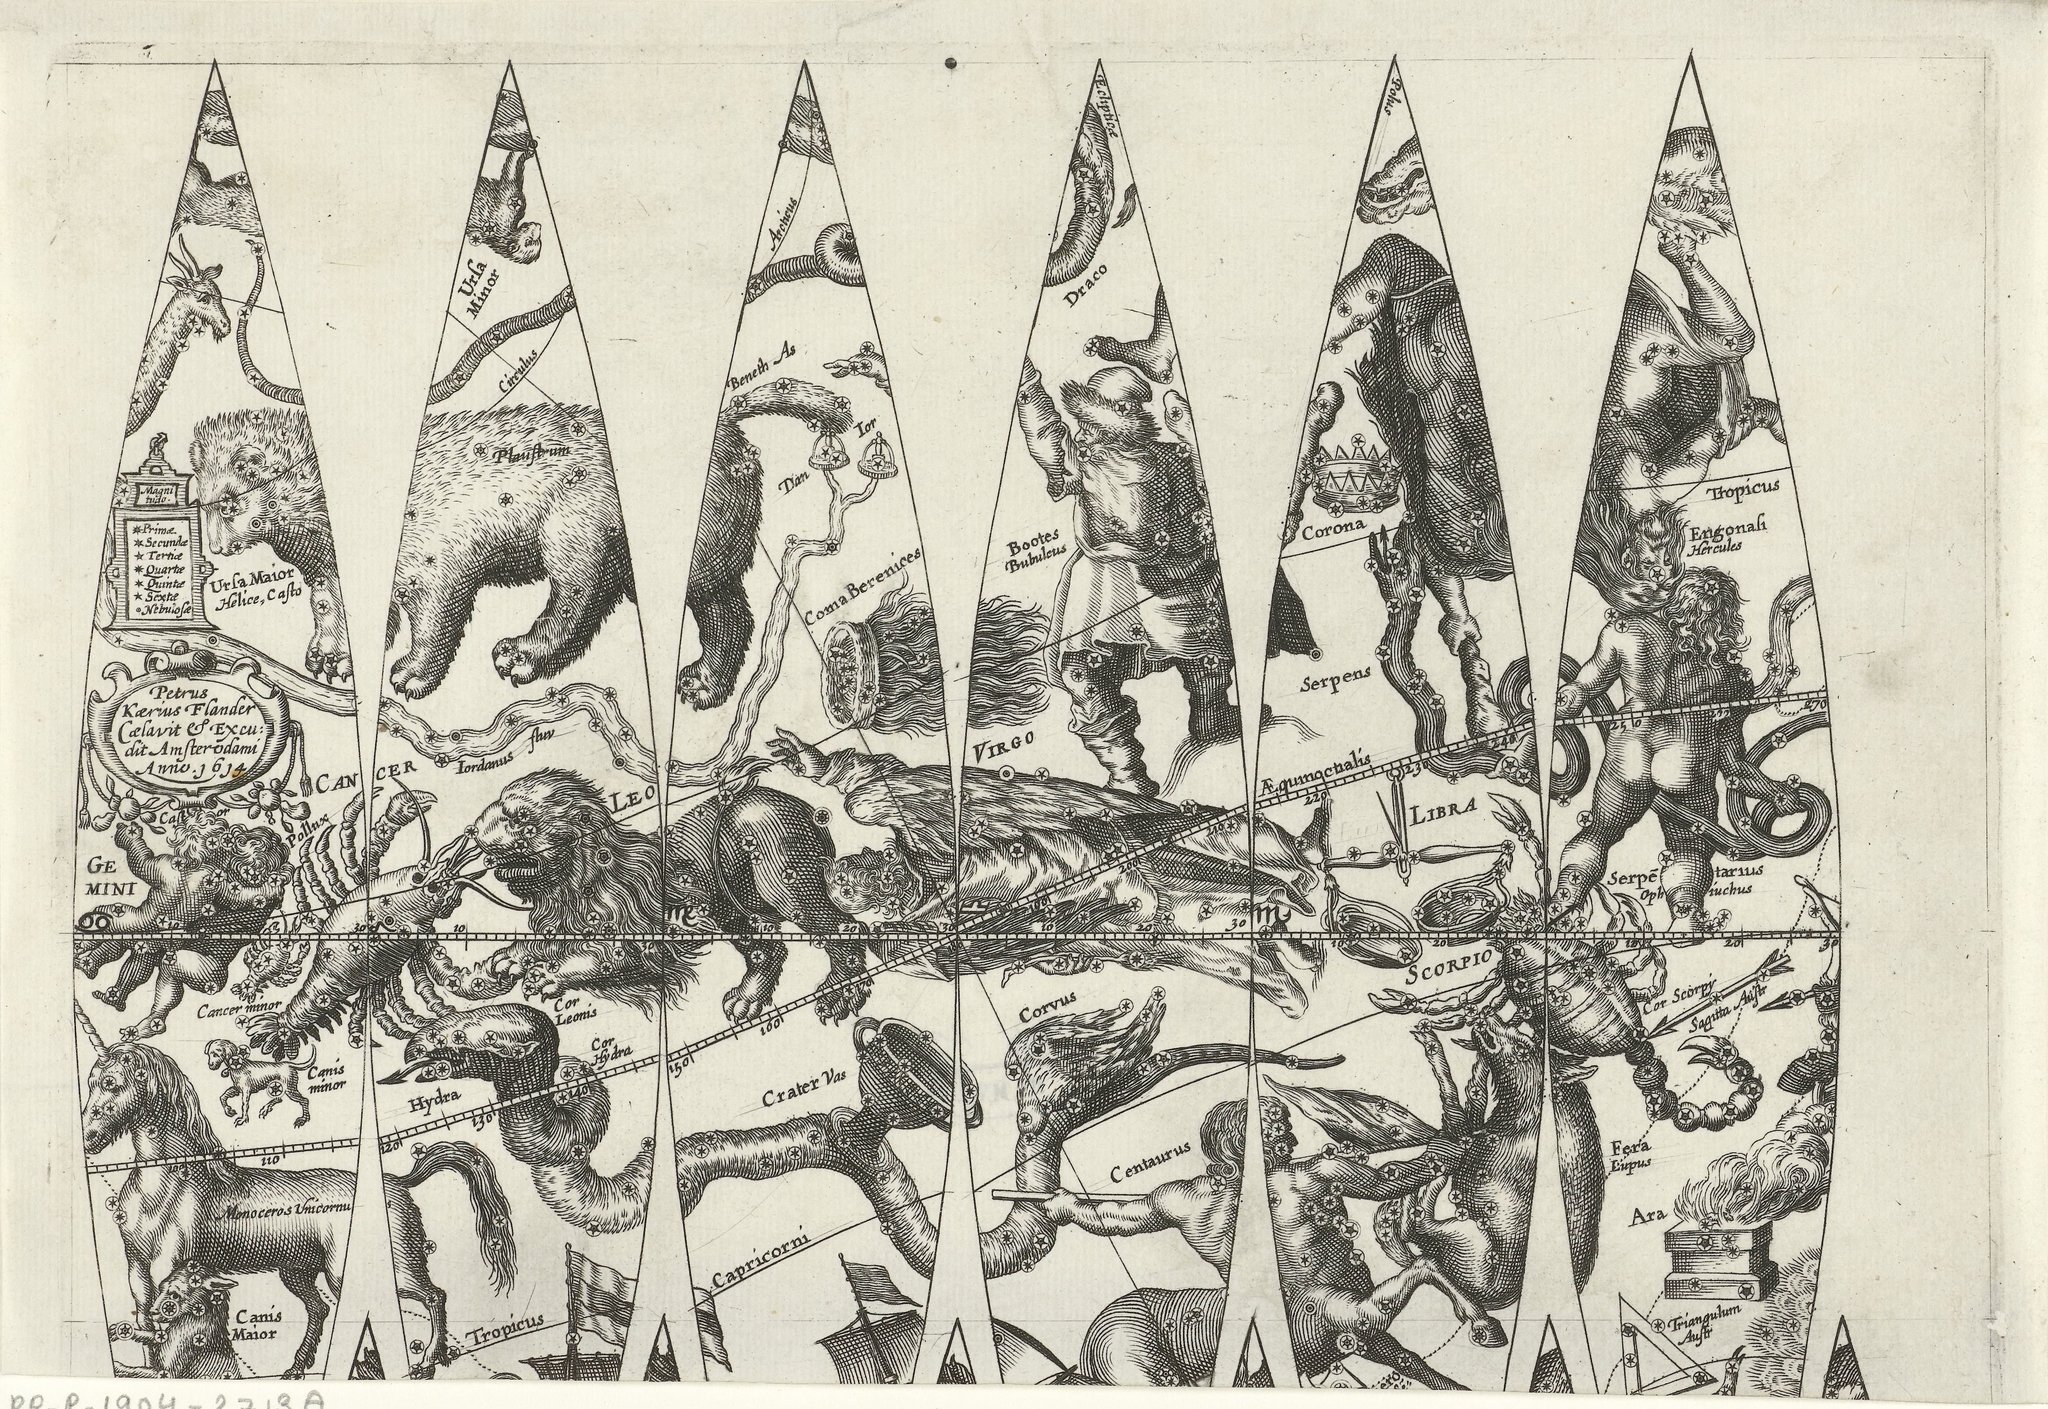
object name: print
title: Kaart van een gedeelte van de dierenriem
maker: pieter van der keere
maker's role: print maker, publisher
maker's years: 1571-1646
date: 1614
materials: paper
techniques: engraving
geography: amsterdam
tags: virgo (zodiacal sign of august), cancer (zodiacal sign of june), scorpio (zodiacal sign of october), gemini (zodiacal sign of may), leo (zodiacal sign of july), star-globe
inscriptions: collector's mark: Lugt 2228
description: Kaart van een gedeelte van de dierenriem met links een cartouche waarin het adres van de uitgever en daarboven een lijst met de namen van verschillende soorten sterren. De sterrenbeelden zijn met hun Latijnse naam aangeduid: rechts de schorpioen, in het midden de maagd, rechtsonder de centaur en links de leeuw, de kreeft en de tweeling. Onderaan is een afgesneden gedeelte van een andere kaart zichtbaar. Deze prent maakt mogelijk onderdeel uit van het blad waarop 'Kaart van een gedeelte van Amerika' van dezelfde prentmaker is gedrukt.